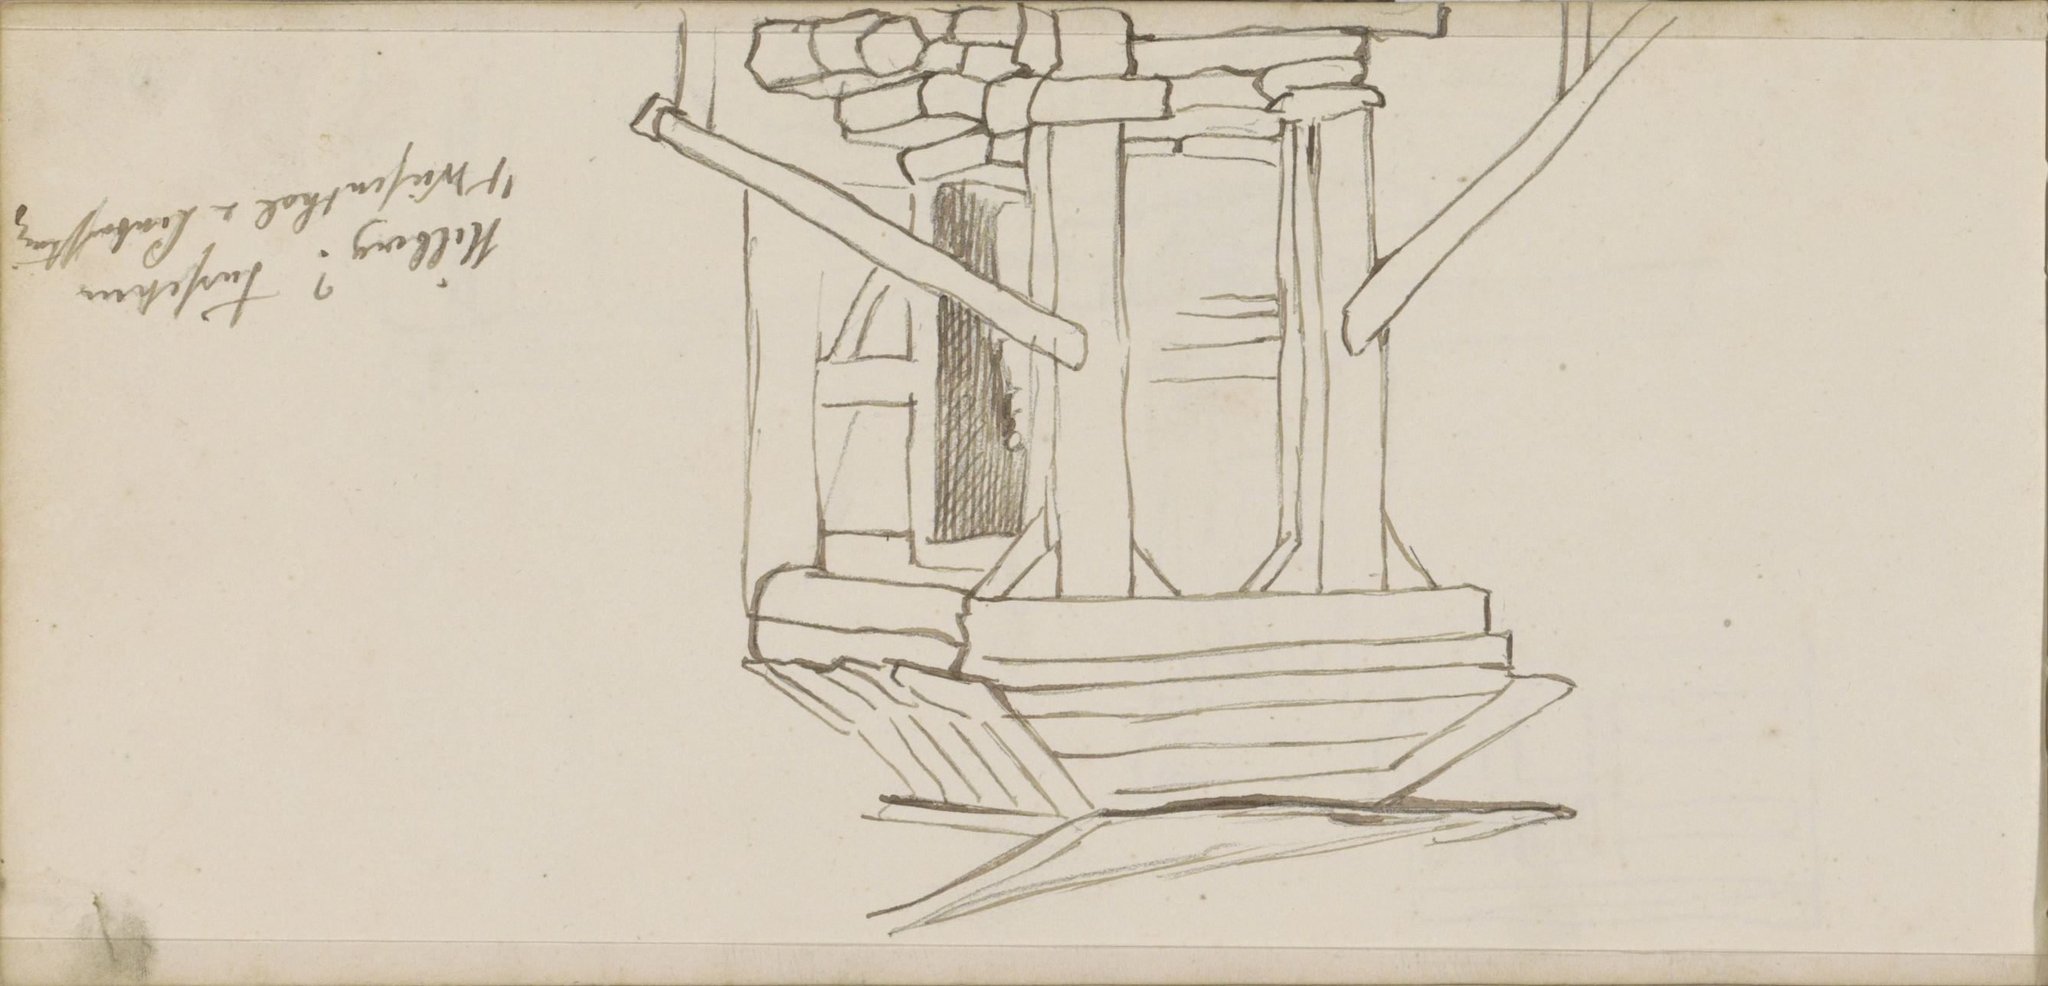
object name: sketchbook leaf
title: Veranda met houten overkapping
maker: johannes tavenraat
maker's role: draughtsman, painter, print maker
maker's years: 1809-1881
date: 1840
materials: ink, paper, pencil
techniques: pen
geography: germany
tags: rural housing, e.g. country-house, villa, cottage, loggia, verandah, porch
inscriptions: date and inscription: ‘Hilberg? tusschen/ 't Wiesenthal & Linba[...]en’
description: Blad 49 verso uit een schetsboek met 63 bladen.